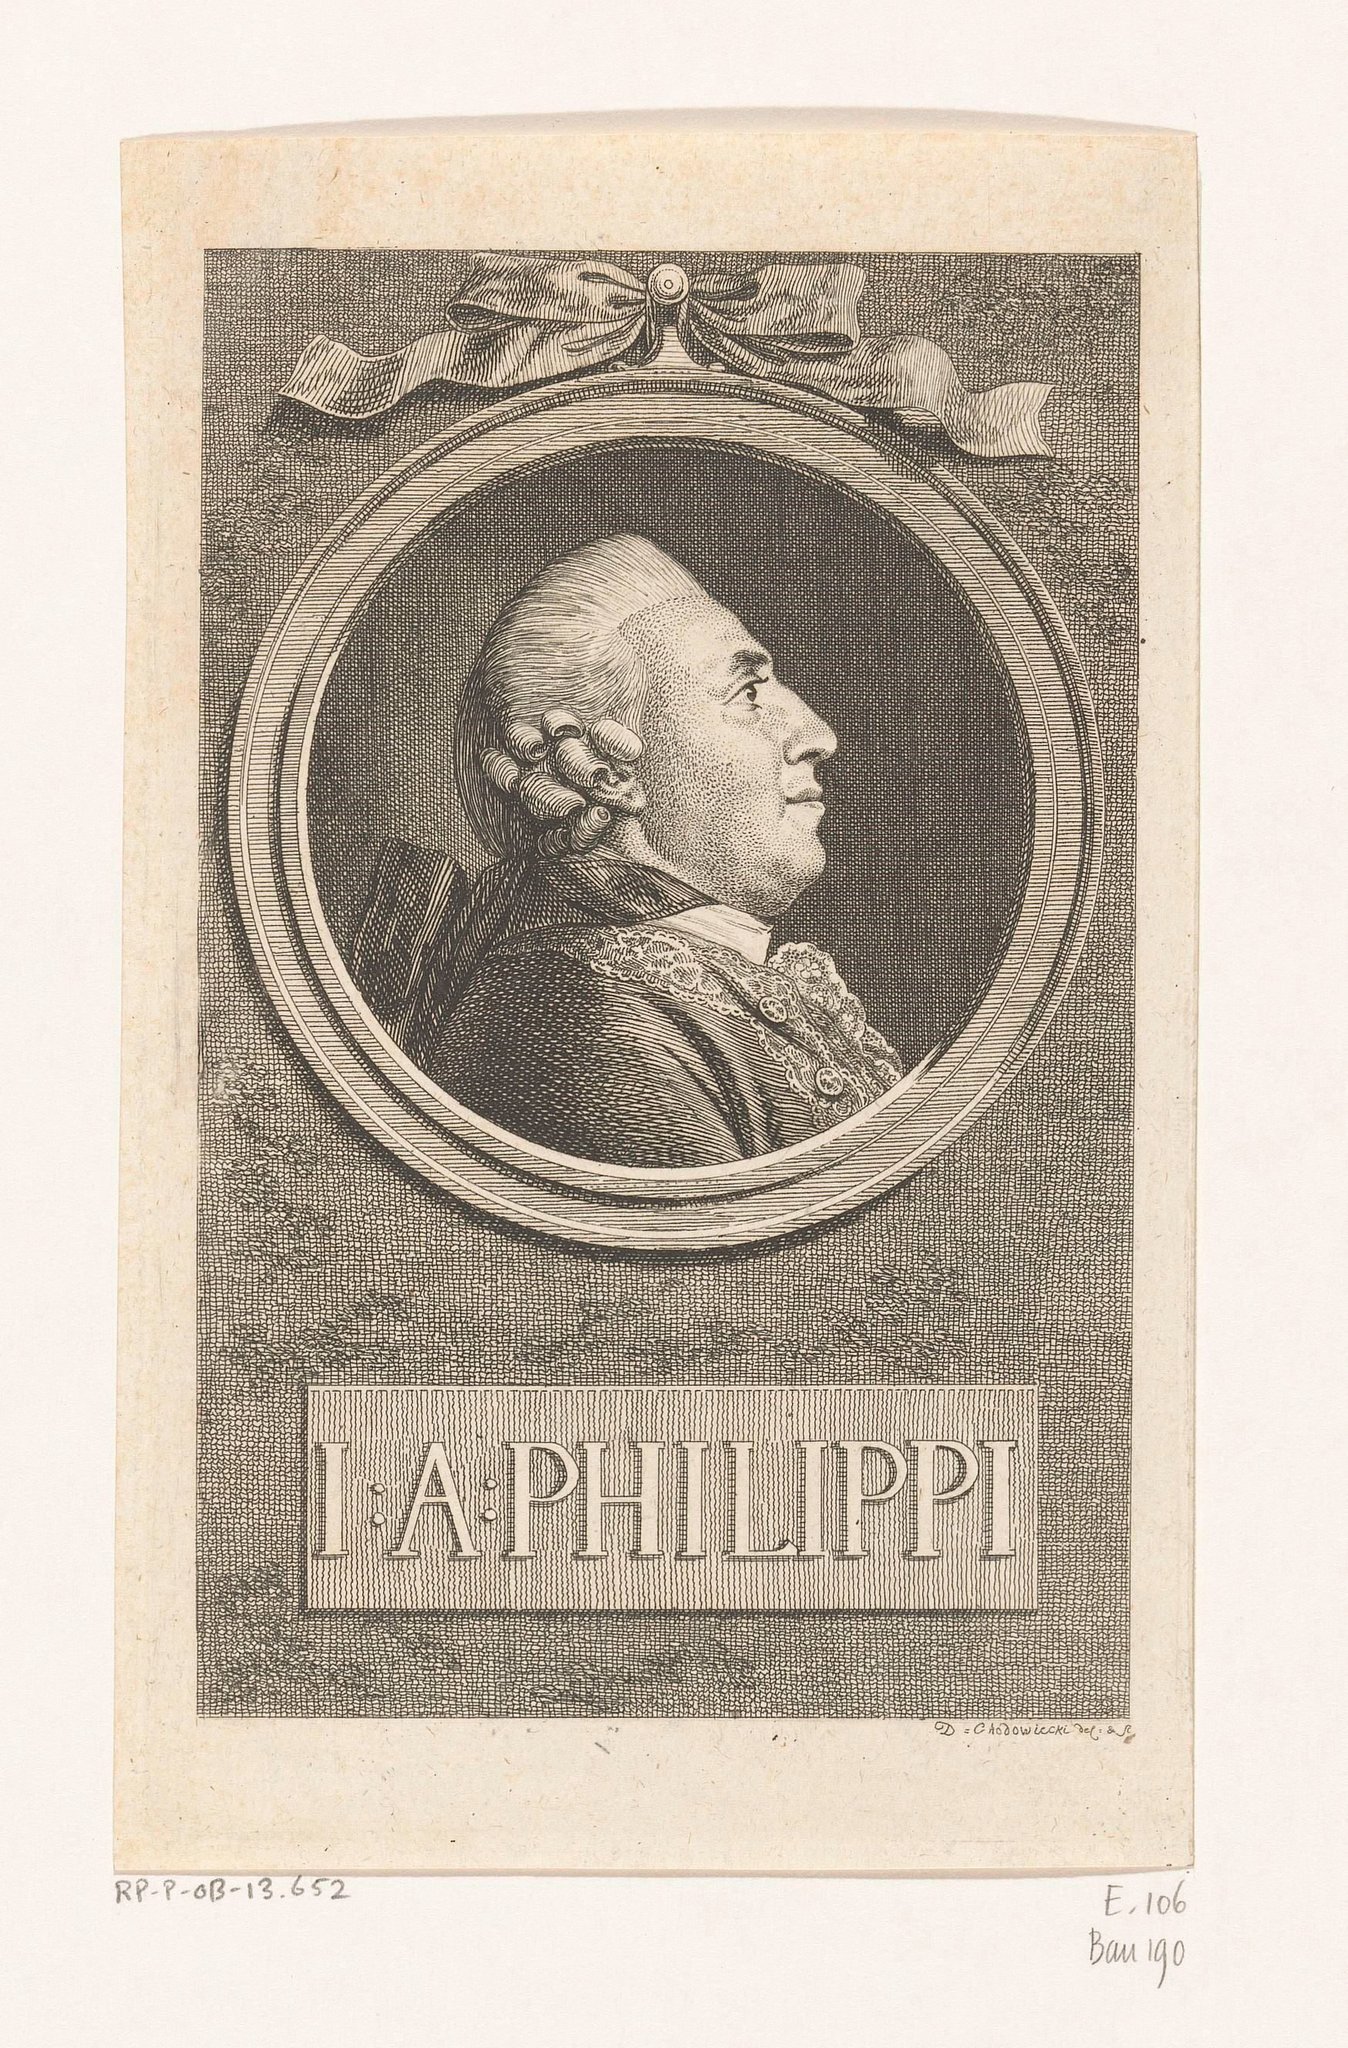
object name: print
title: Portret van Johann Albrecht Philippi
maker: daniel nikolaus chodowiecki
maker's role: draughtsman, print maker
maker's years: 1726-1801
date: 1773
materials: paper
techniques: etching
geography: berlin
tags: historical persons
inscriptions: collector's mark: Lugt 2228, inscription: ‘C - 12’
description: Prent ook gebruikt in: Krünitz, Johann Georg. Oekonomische Encyklopädie. Berlijn: Joachim Pauli, 1774, dl. 3.